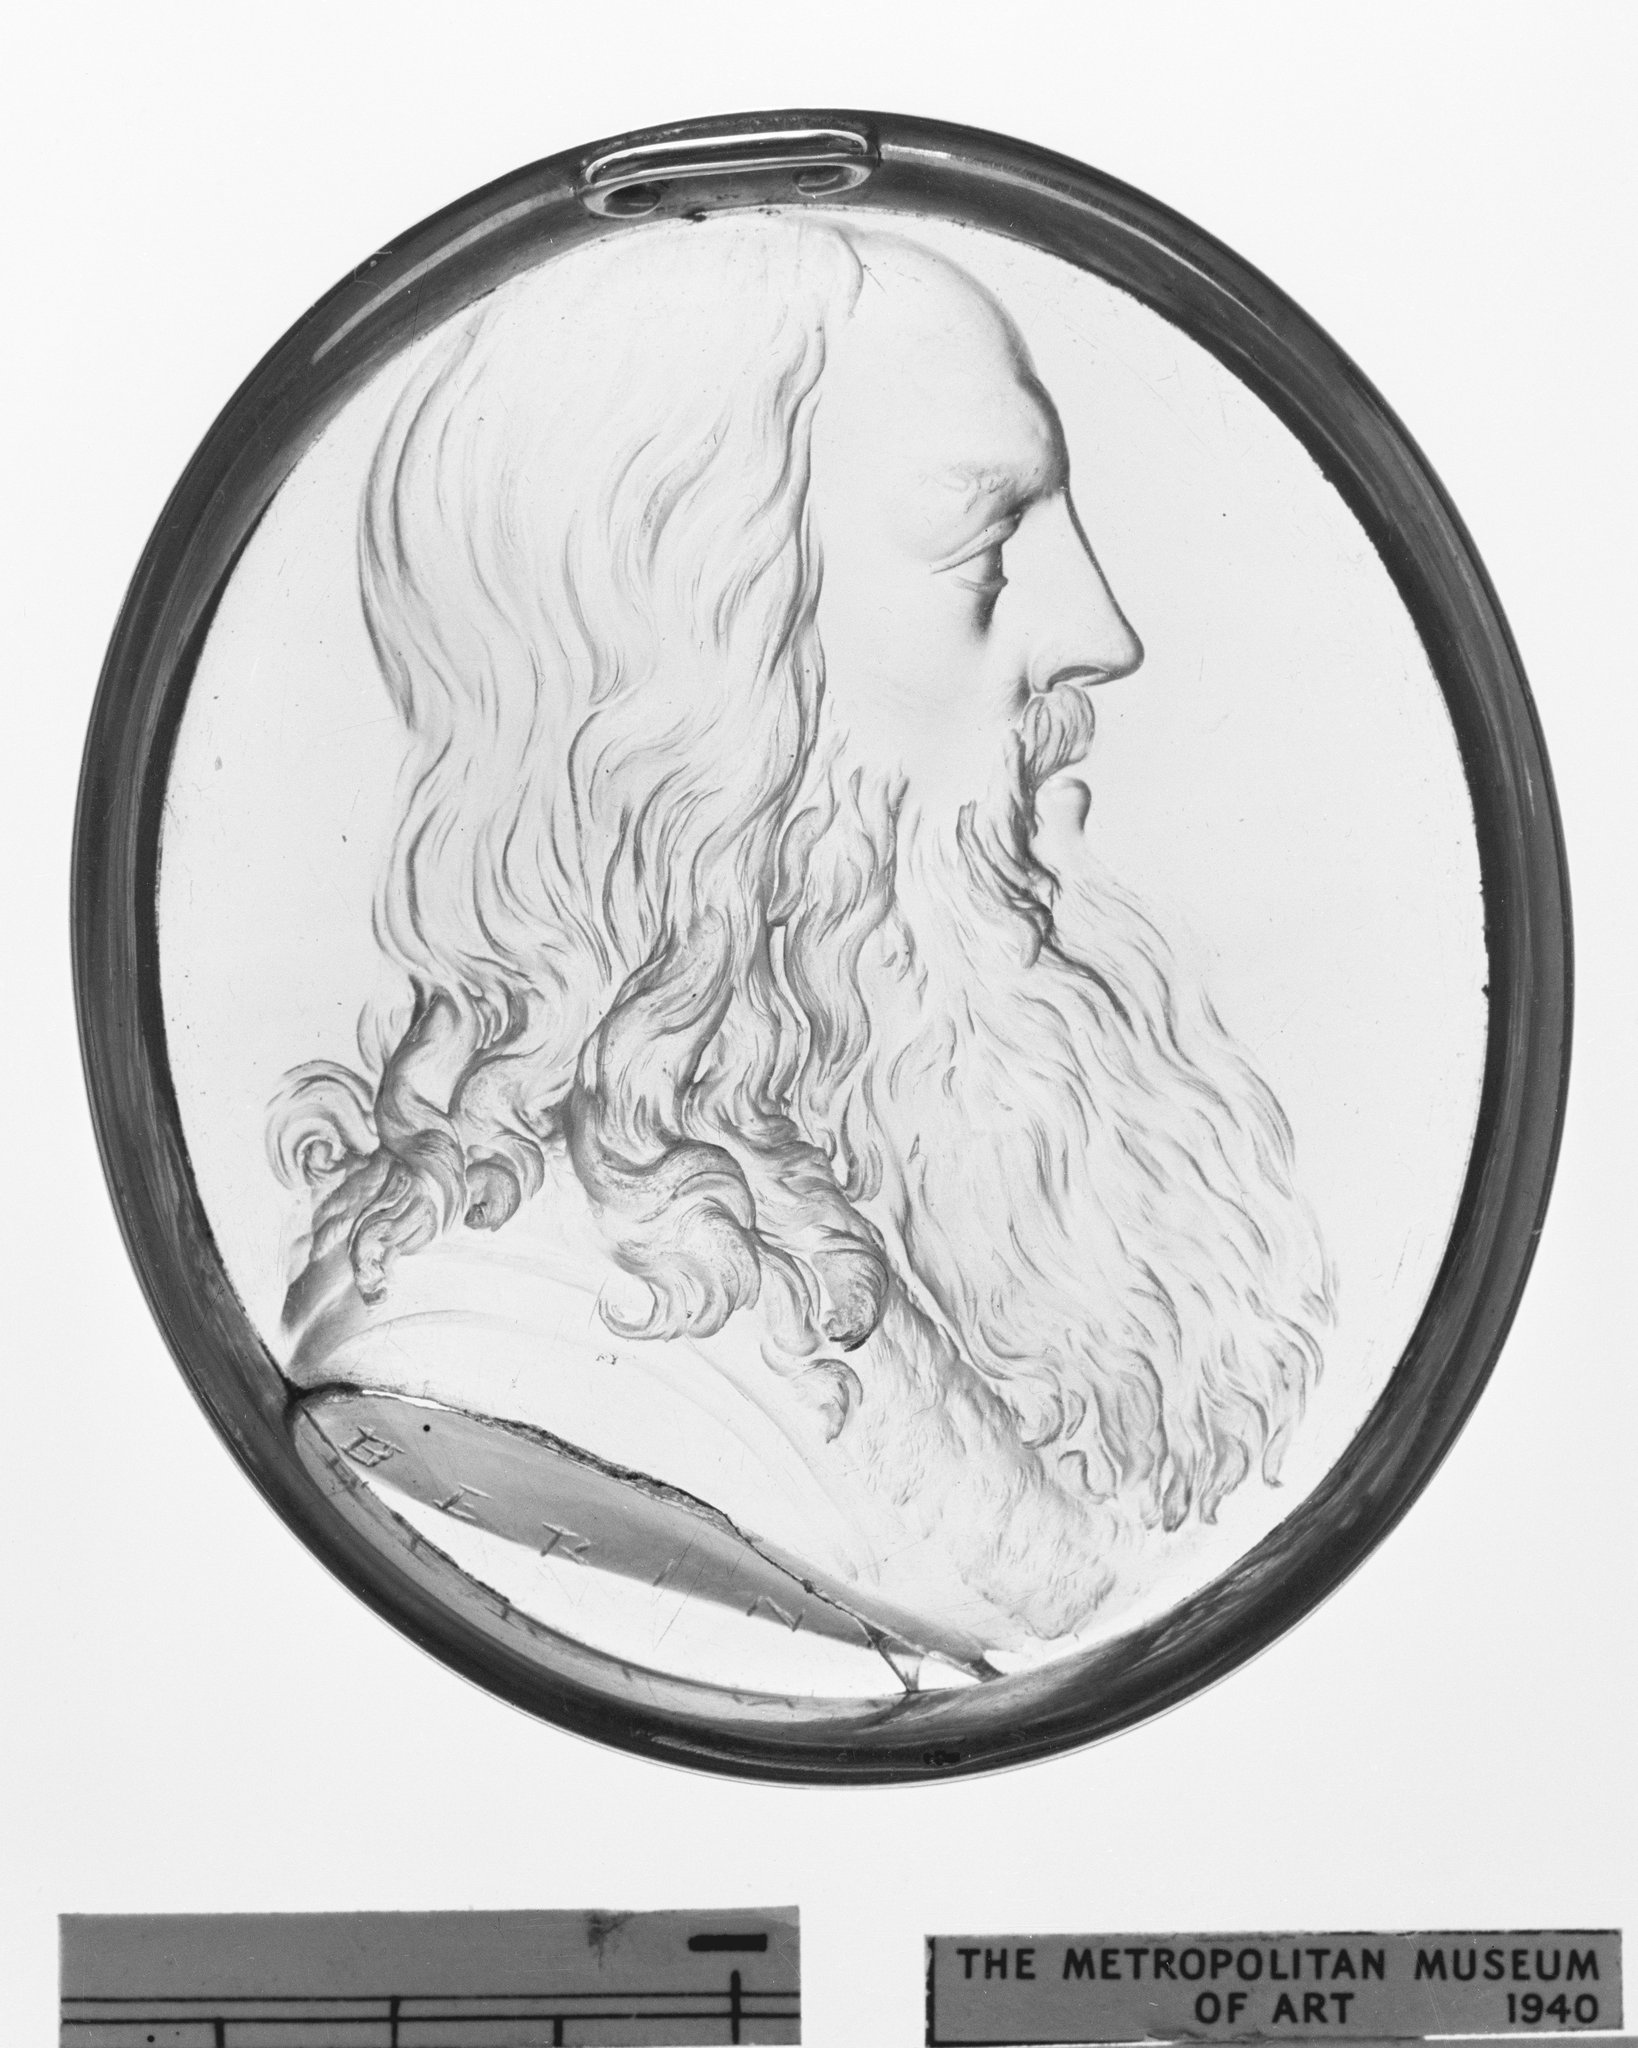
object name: intaglio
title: Leonardo da Vinci (1452–1519)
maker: antonio berini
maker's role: artist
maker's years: 1770-1830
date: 1801-1833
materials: glass, gold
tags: men,profiles